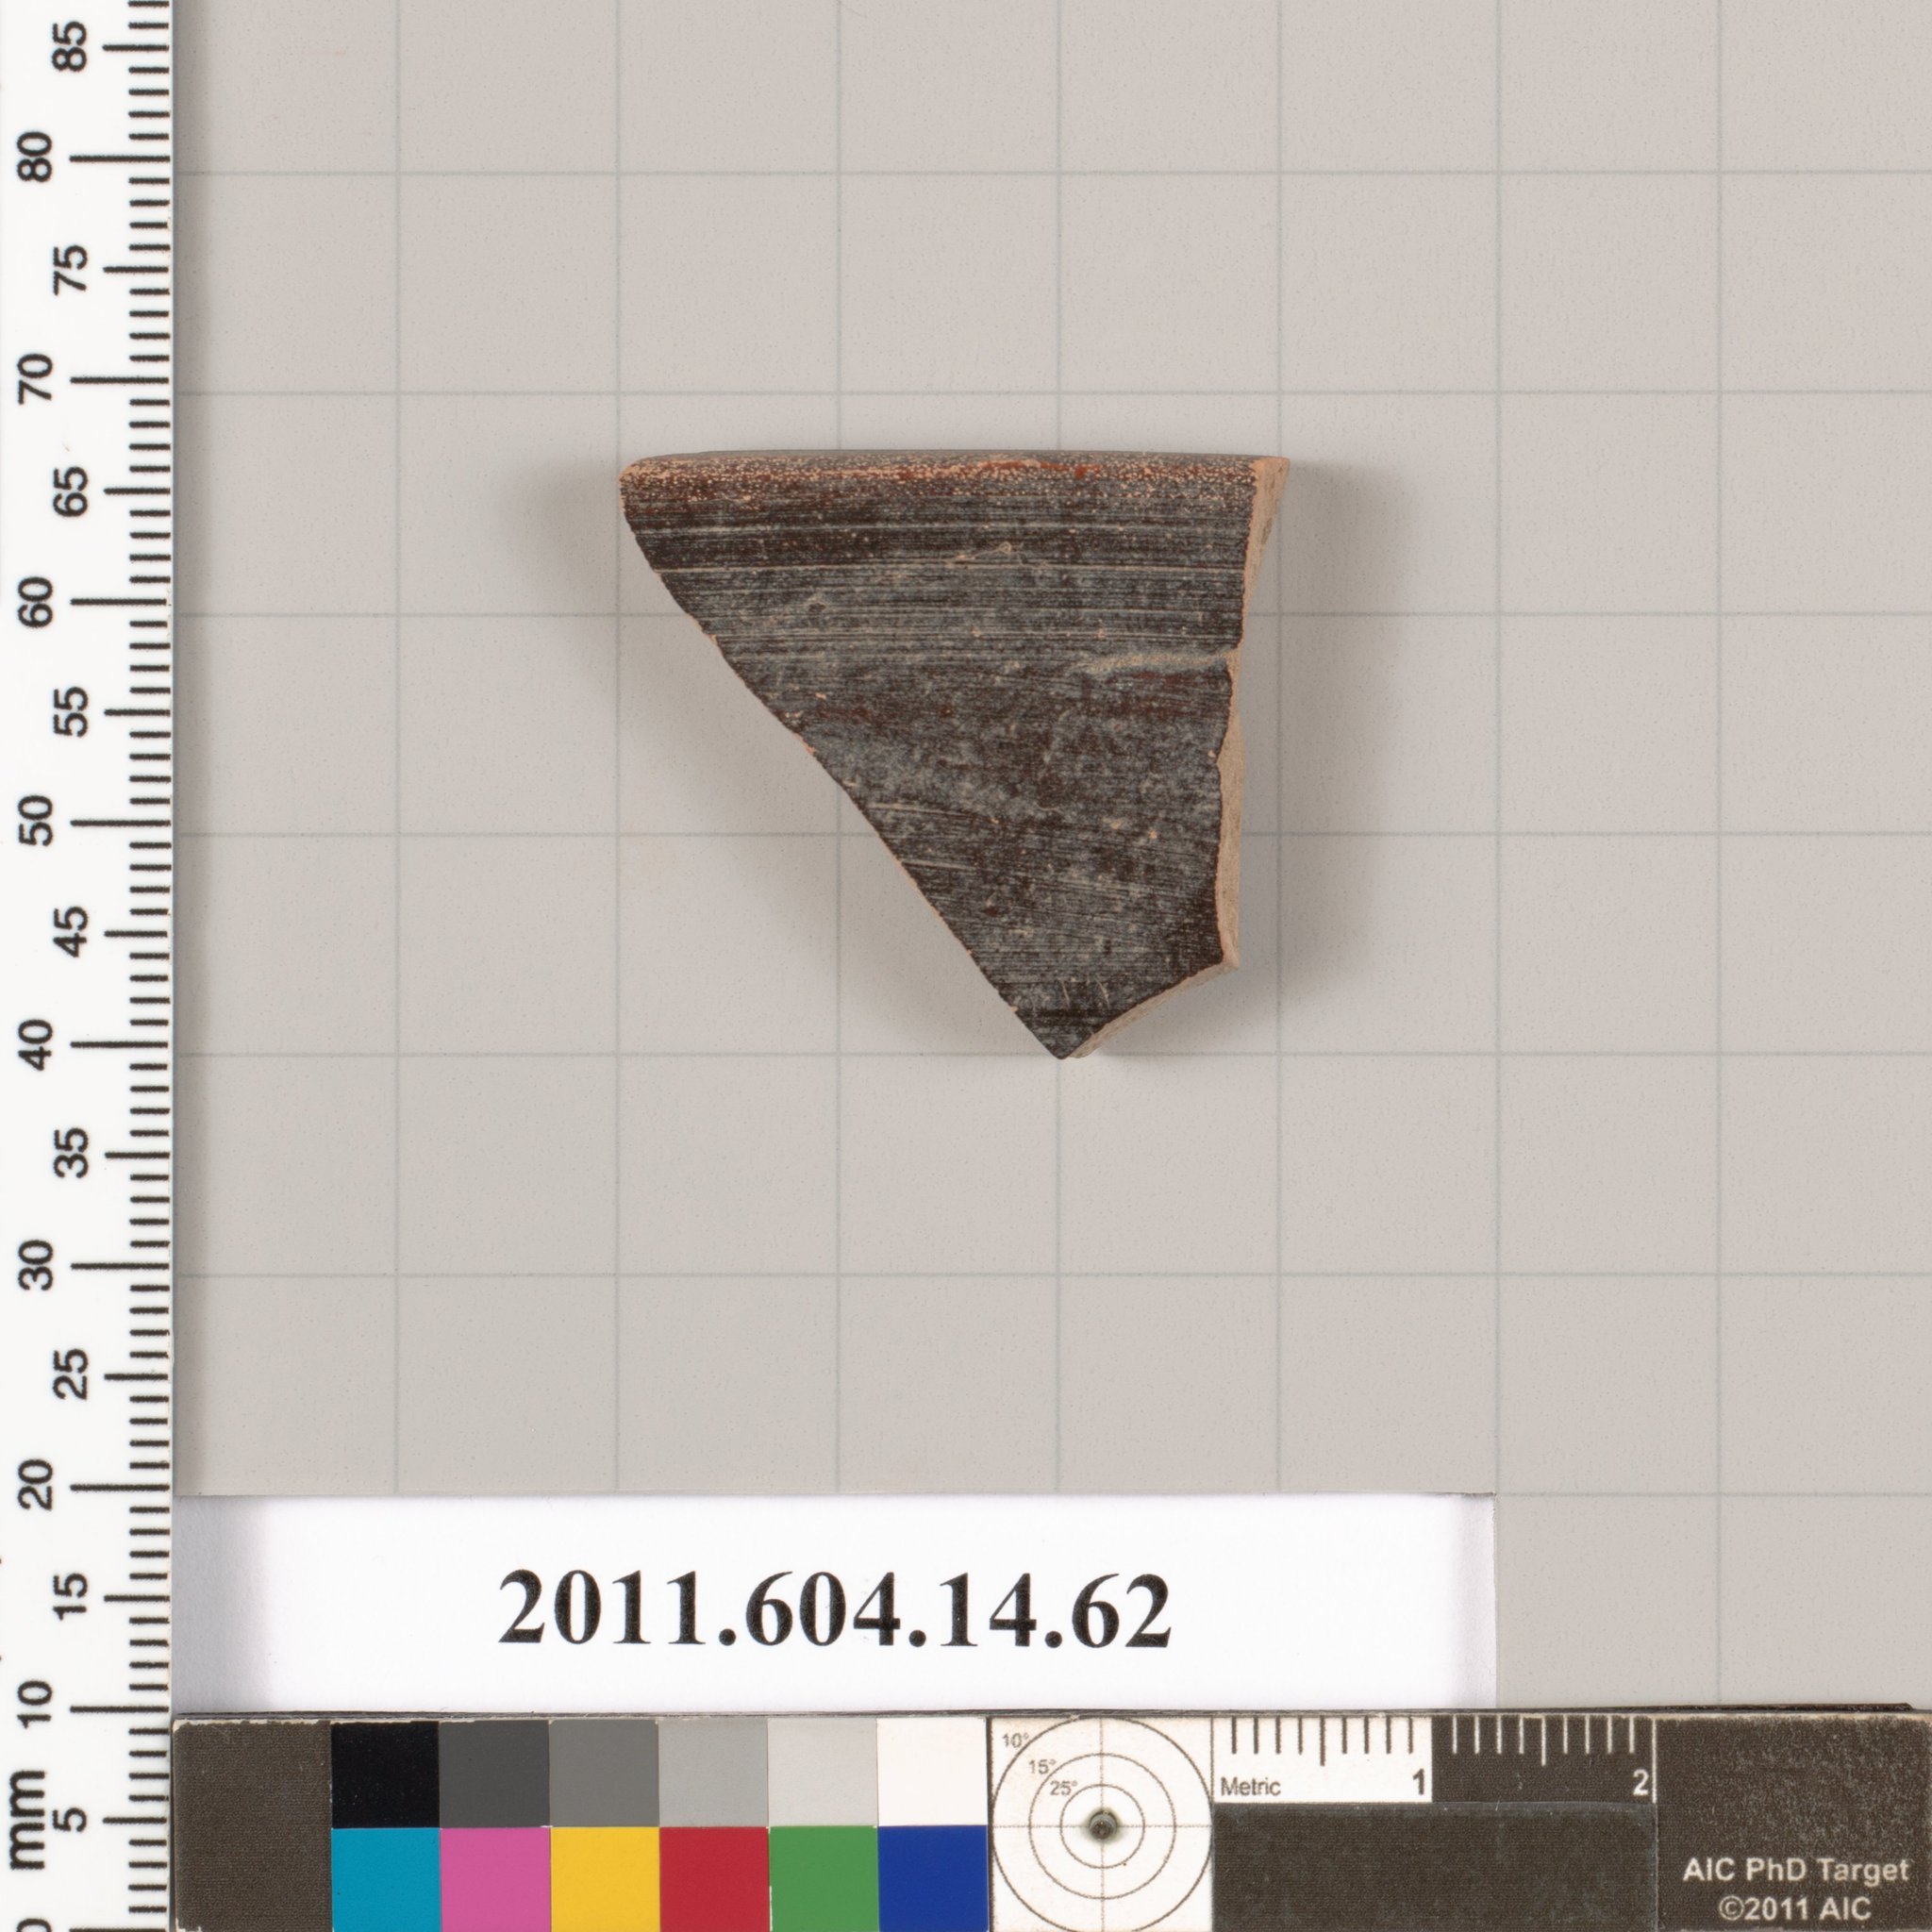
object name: undetermined open shape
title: Terracotta rim fragment of an open shape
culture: unknown fabric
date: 600-301 BCE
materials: terracotta